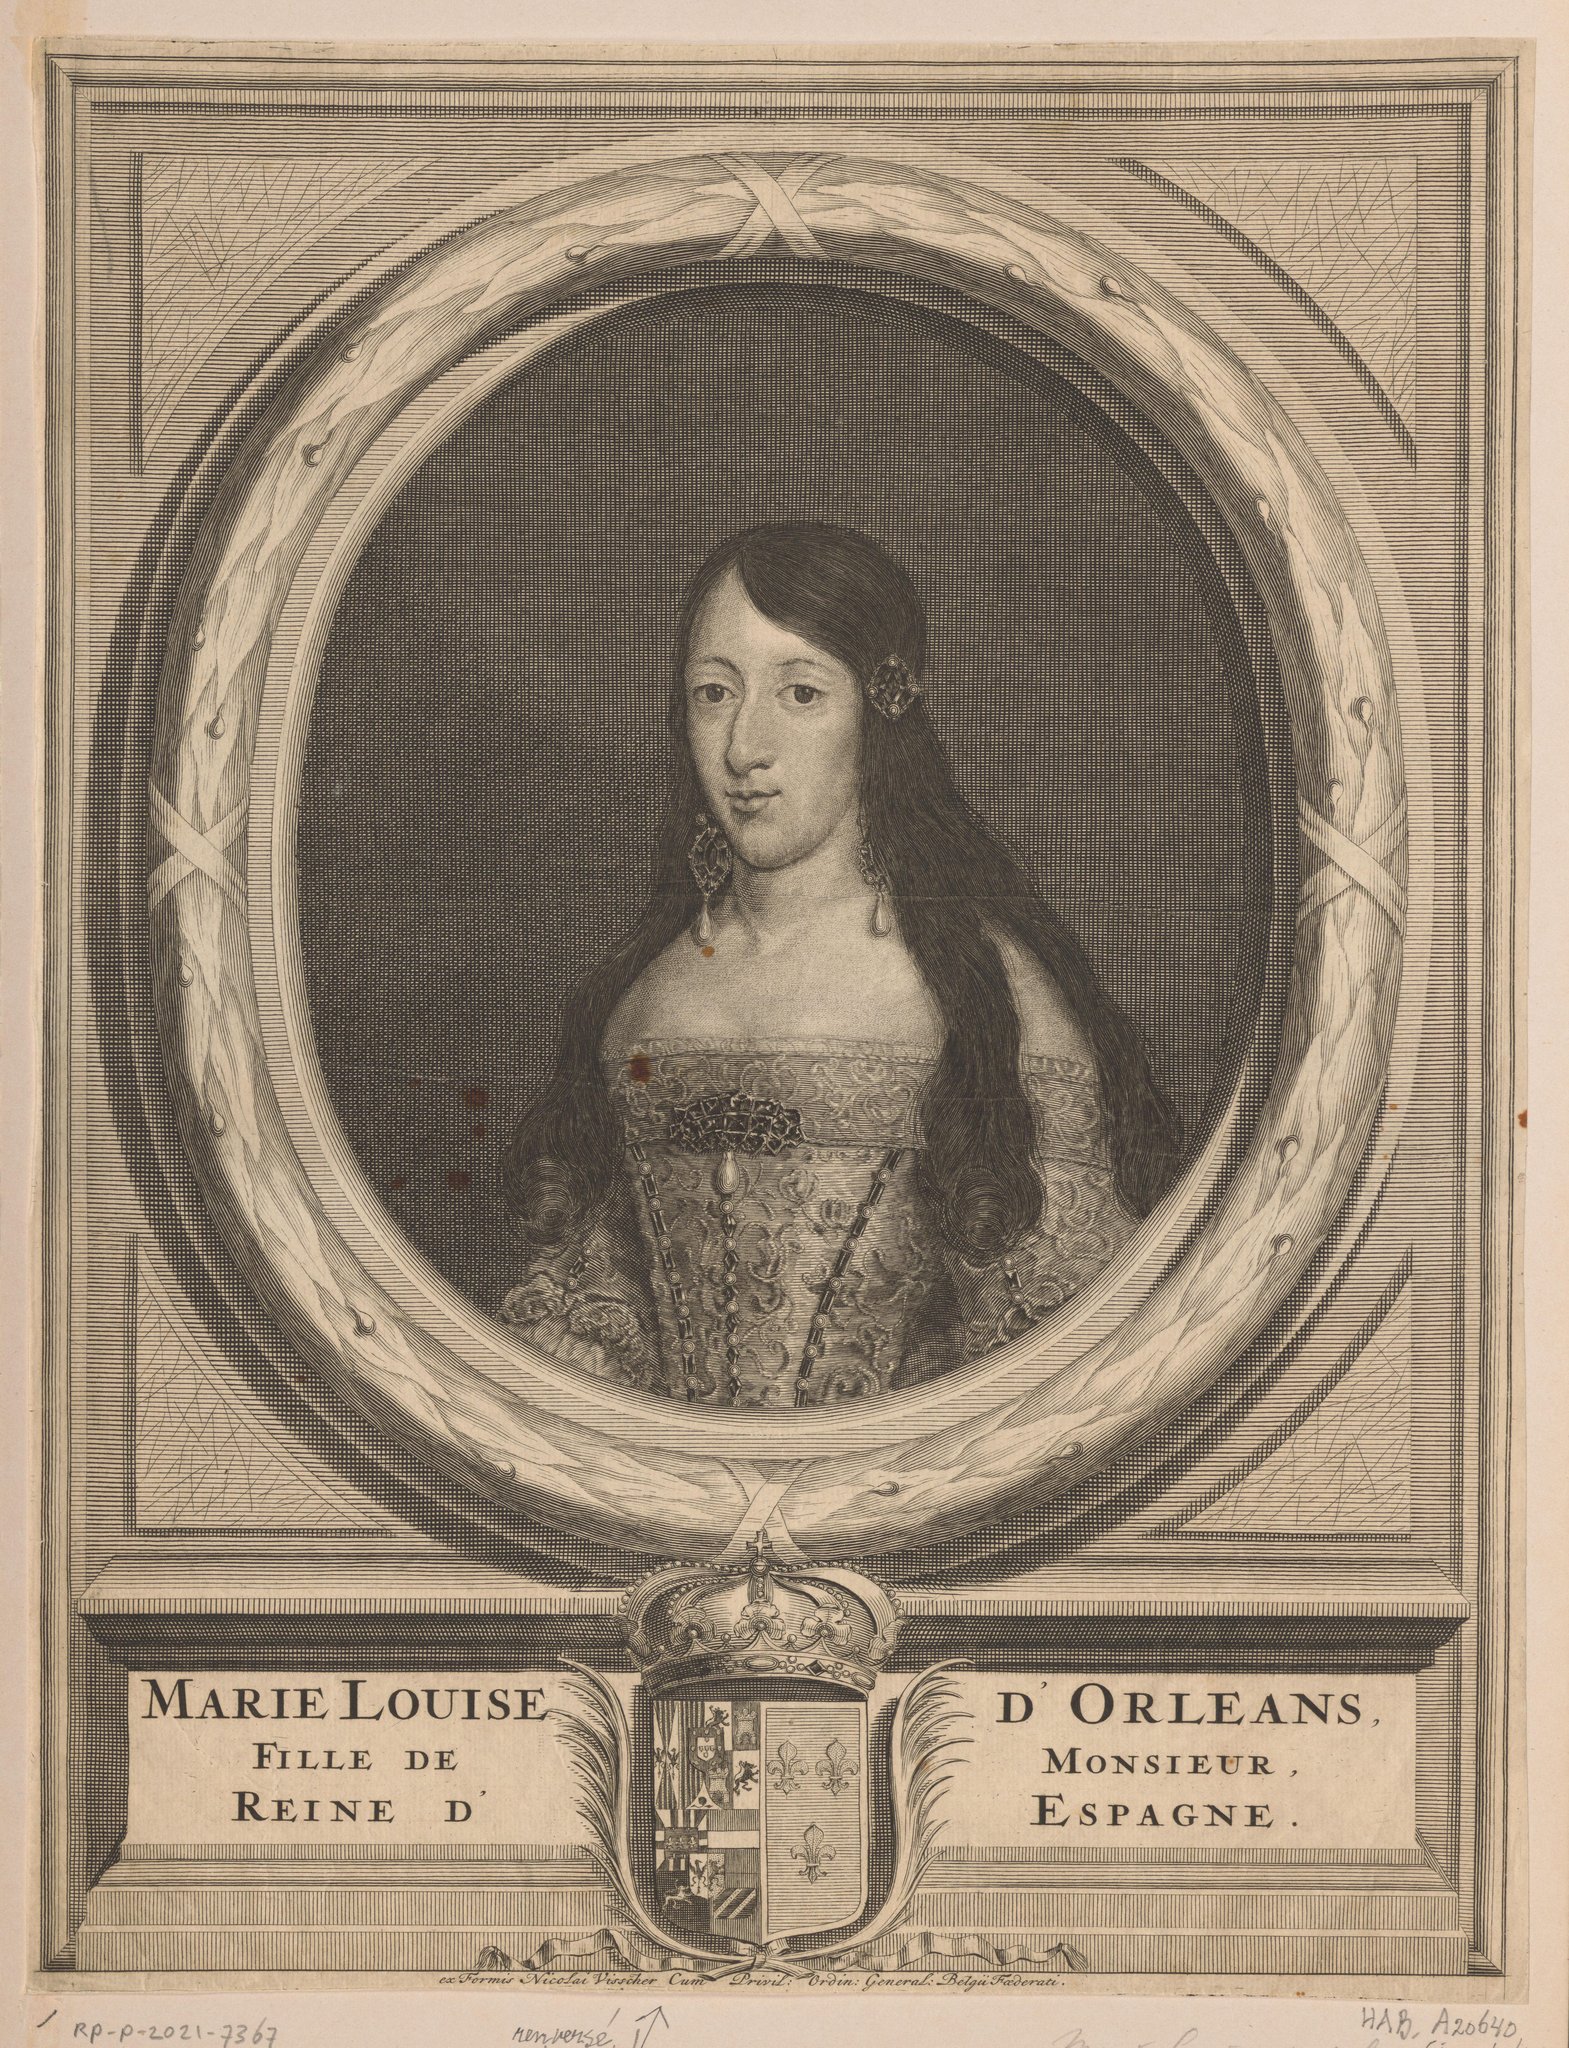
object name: print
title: Portret van Marie Louise van Orléans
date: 1679-1689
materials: paper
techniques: engraving, etching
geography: northern netherlands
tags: historical persons - bb - woman, ornament ~ medallion, armorial bearing, heraldry